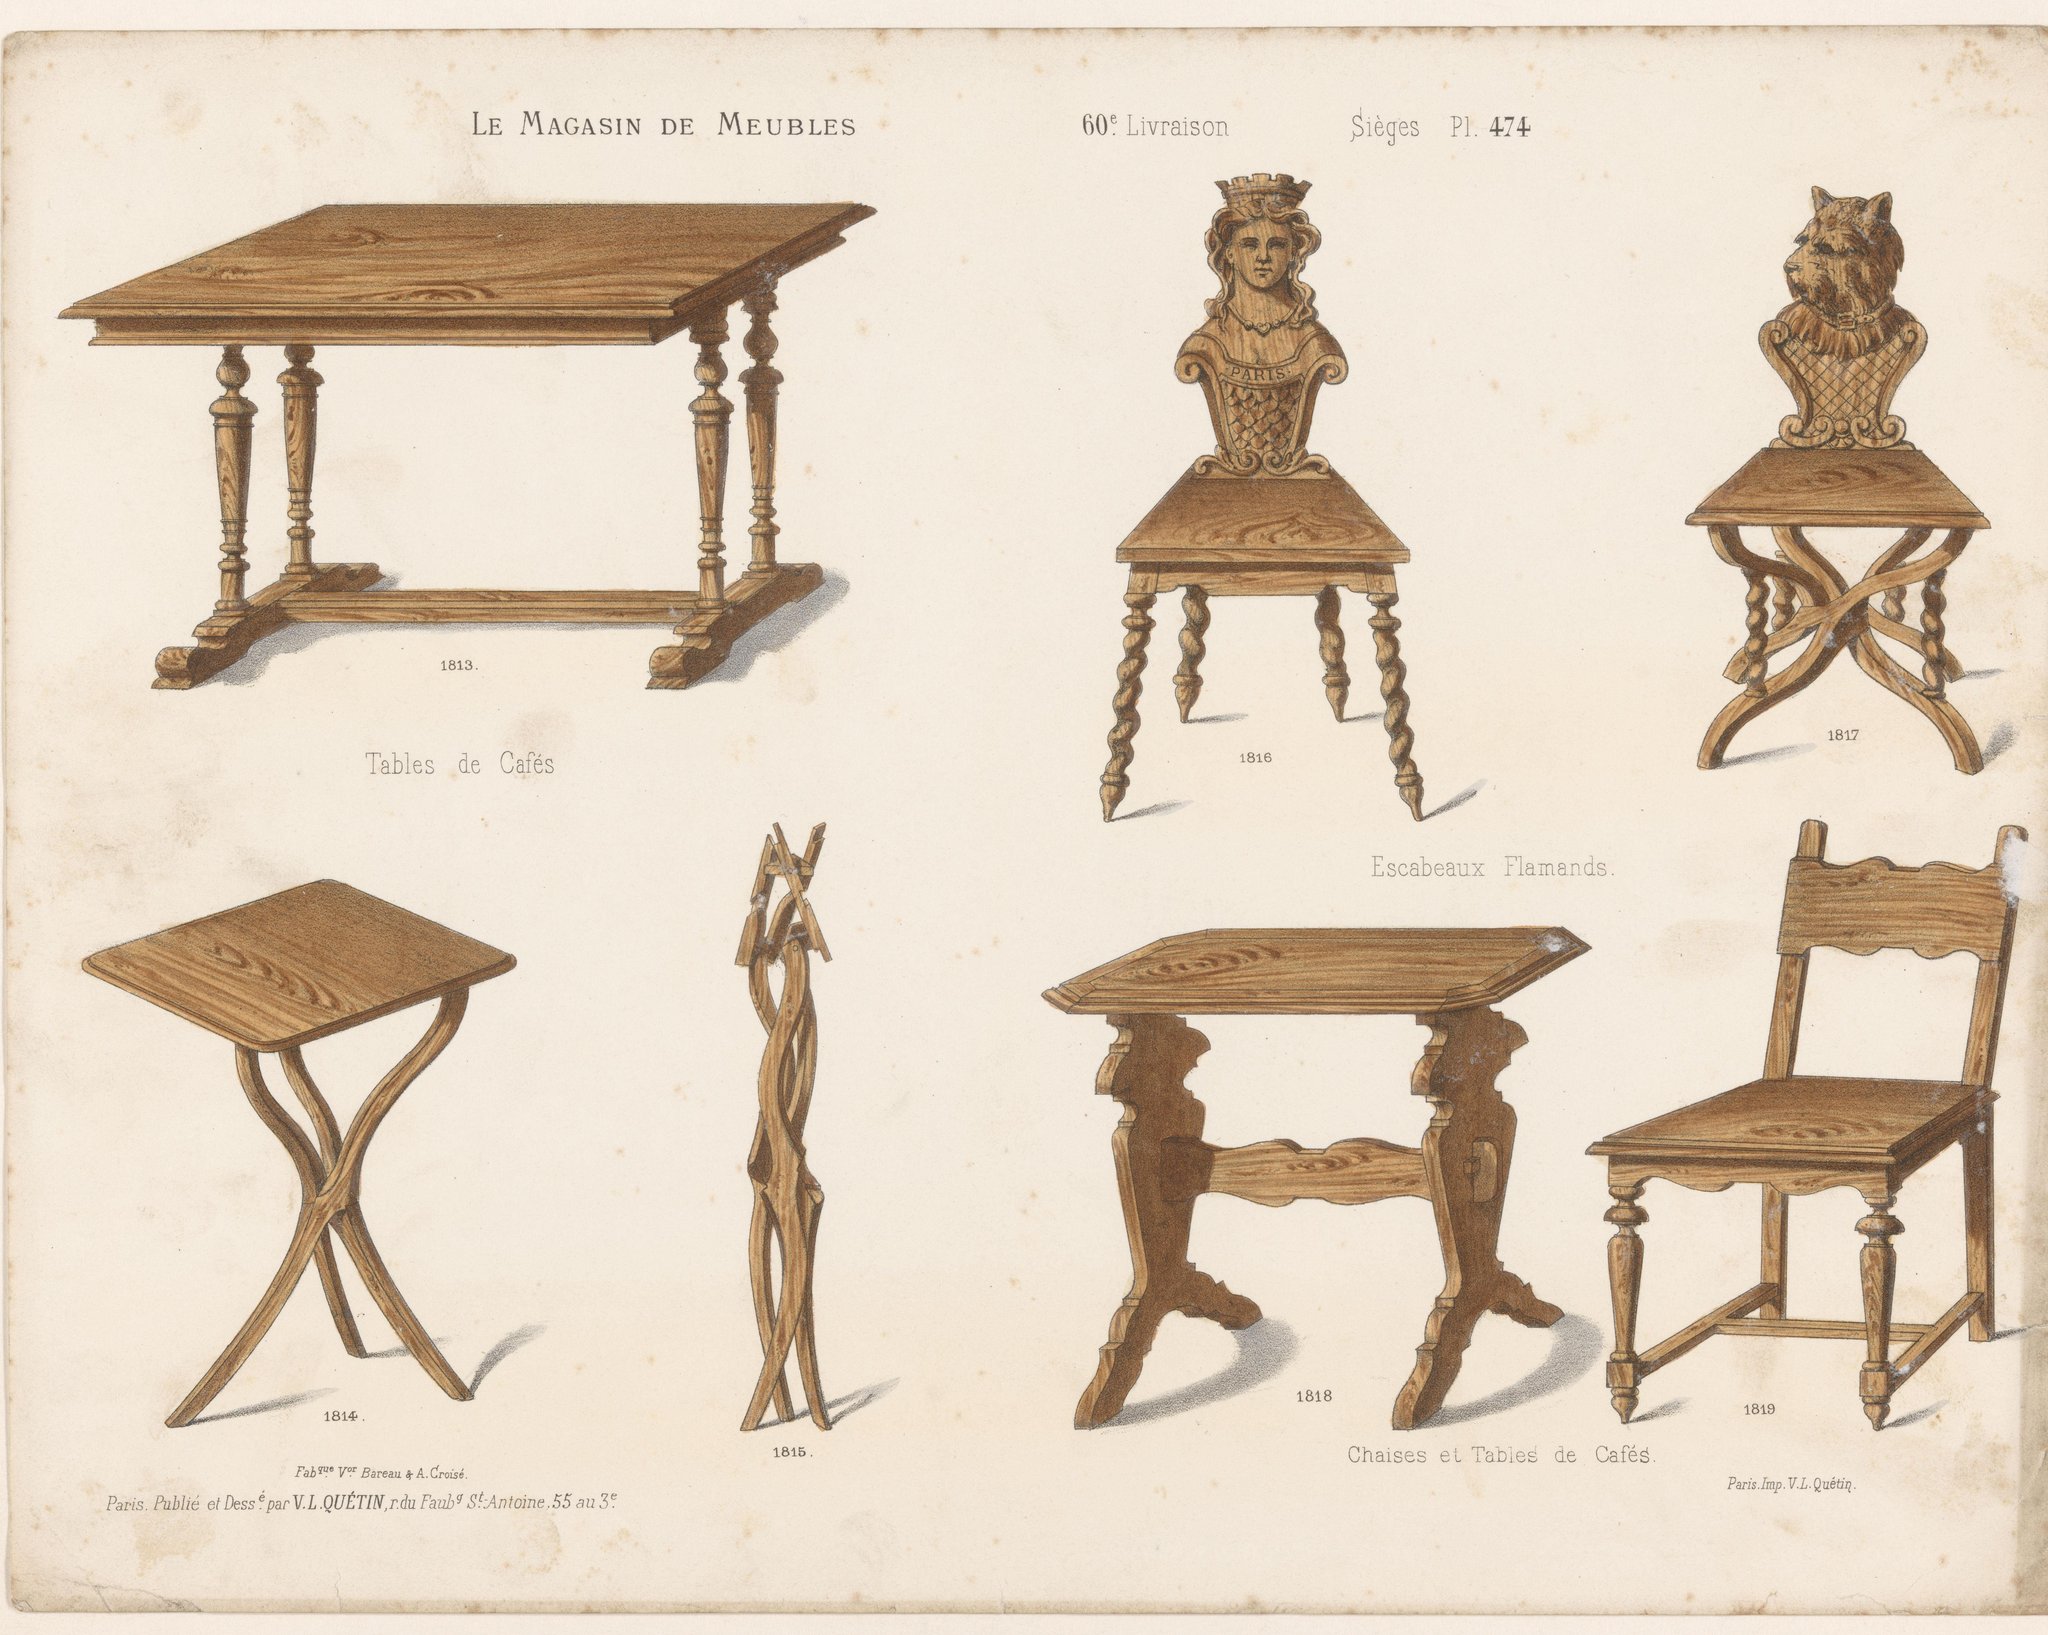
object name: print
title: Le Magasin de Meubles / Sièges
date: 1878-1904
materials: paper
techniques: hand coloring, lithograph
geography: paris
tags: seating furniture, table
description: Tafels en stoelen bestemd voor cafés en twee krukken met inklapbaar rugsteun (escabeau). Prent uit 60e Livraison.